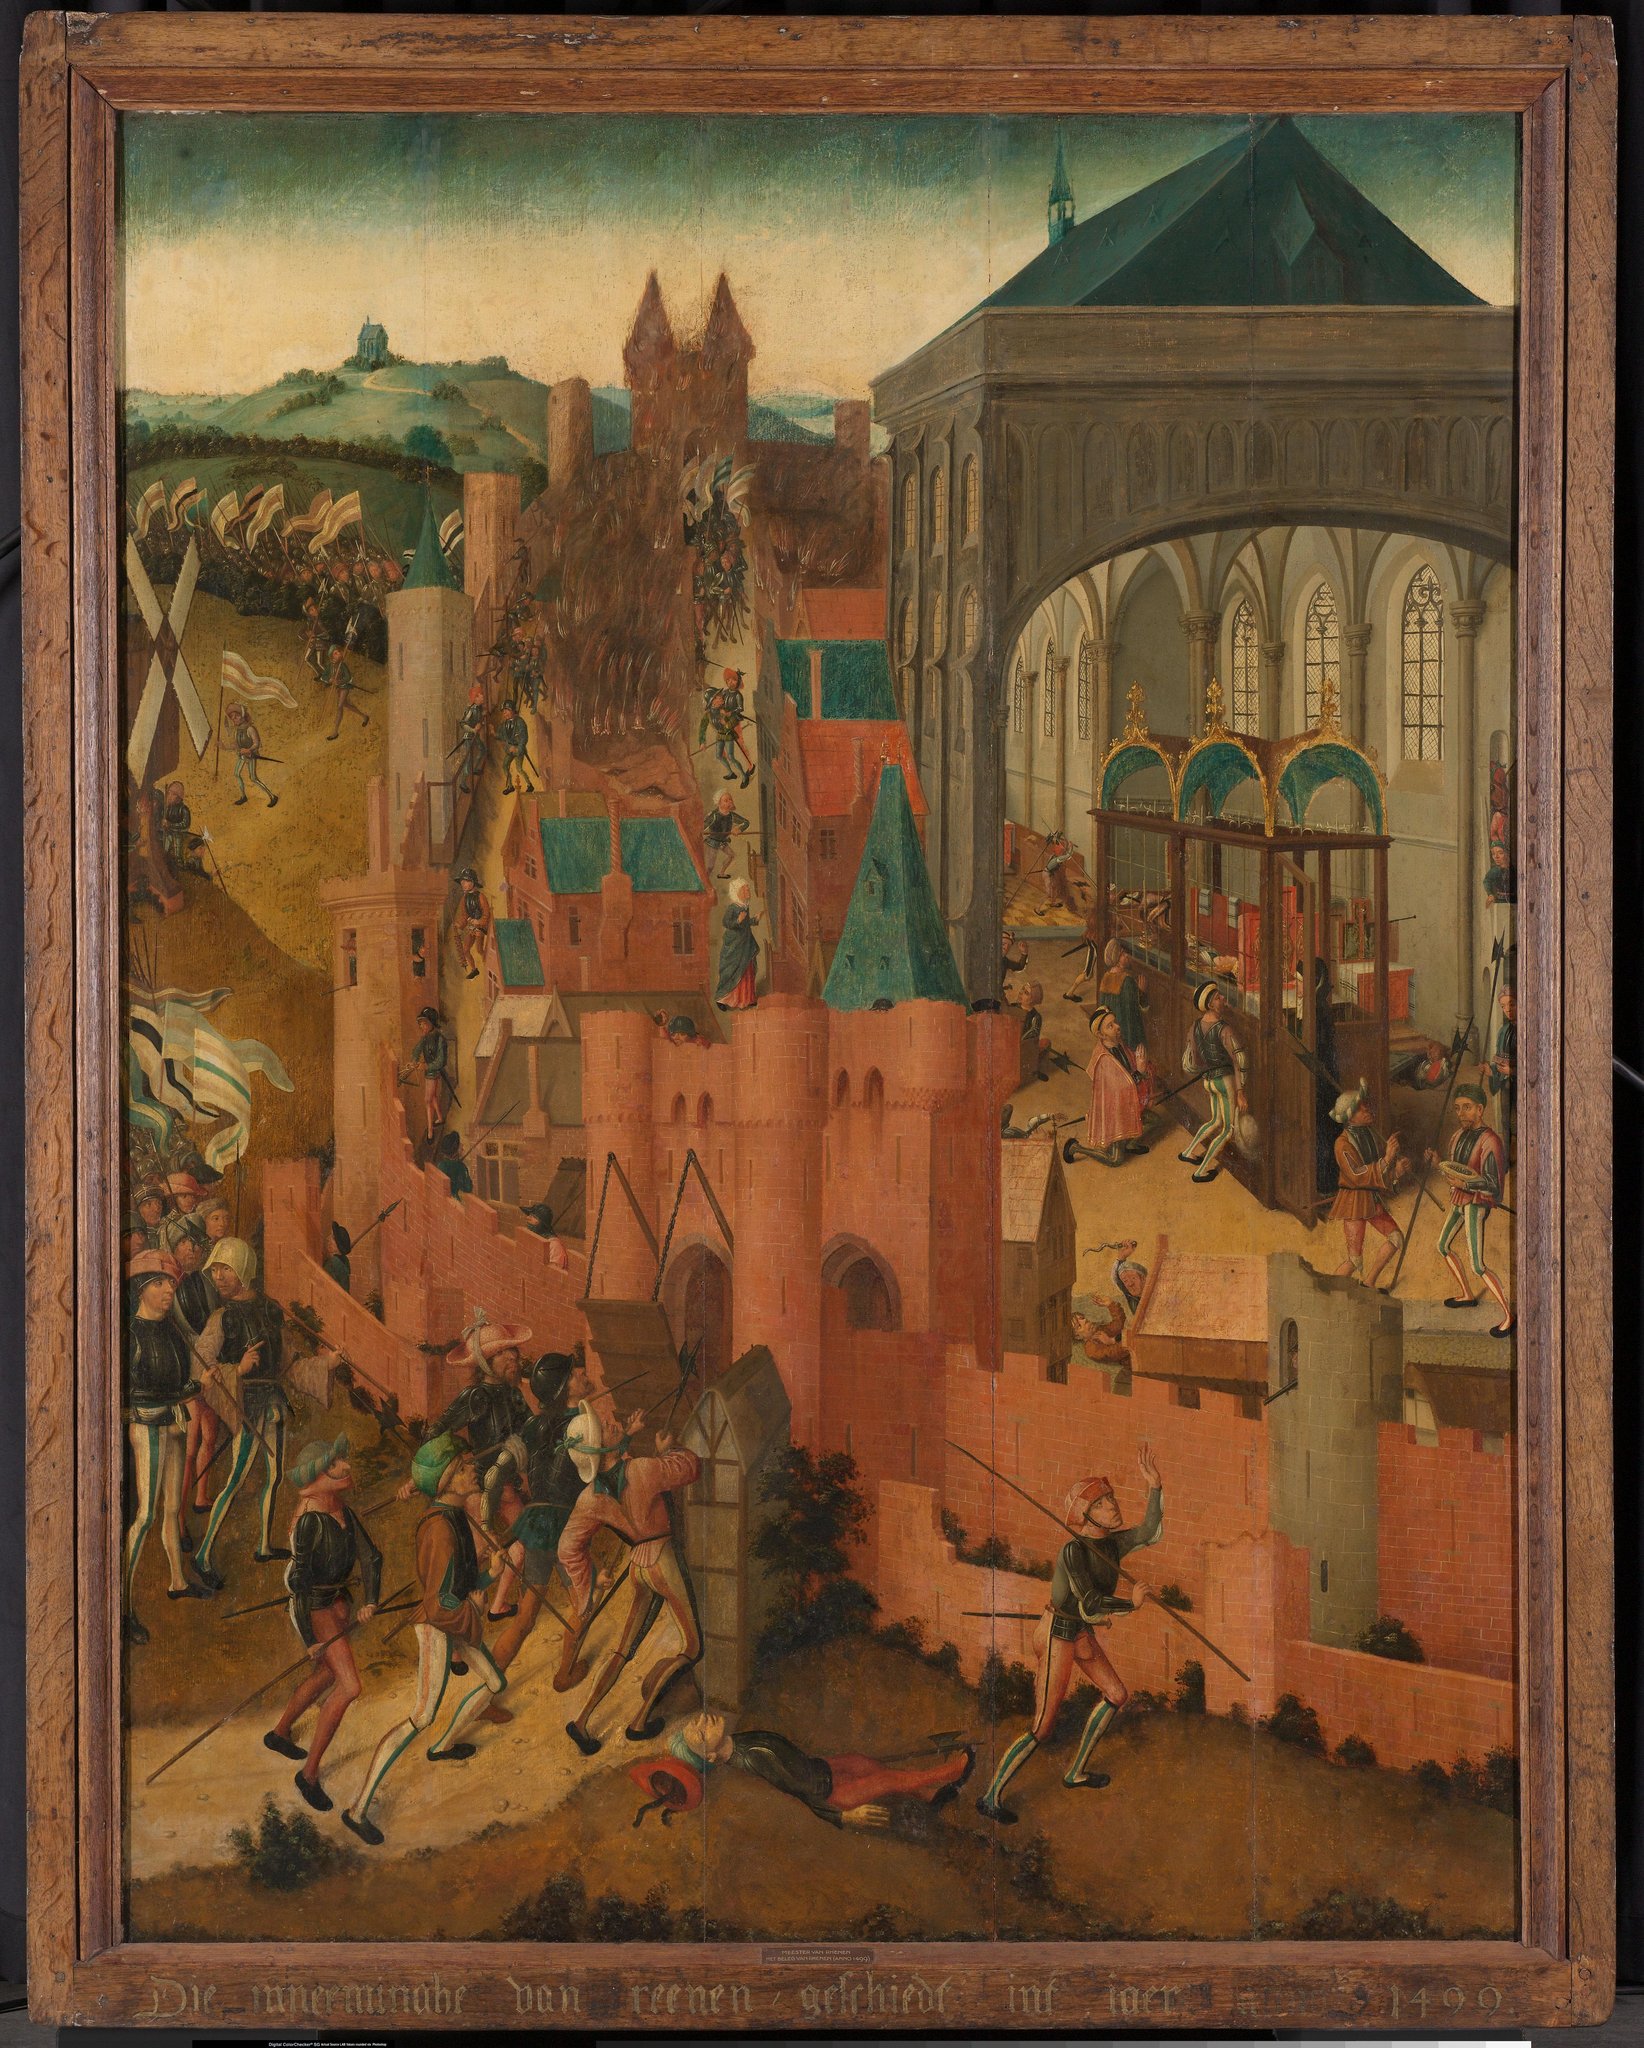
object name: painting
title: The Siege of Rhenen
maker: master of rhenen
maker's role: painter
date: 1499-1525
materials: oil, paint, panel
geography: northern netherlands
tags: city-gate, siege, one person praying, rhenen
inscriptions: inscription, lower sill of the frame: ‘Die inneeminghe van reenen geschiedt int jaer anno 1499’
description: On 8 July 1499, soldiers of the Duke of Guelders marched into the town of Rhenen in the province of Utrecht, setting fire to houses as they went. The Duke was attempting to expand his power base, but the attack failed and his troops retreated.